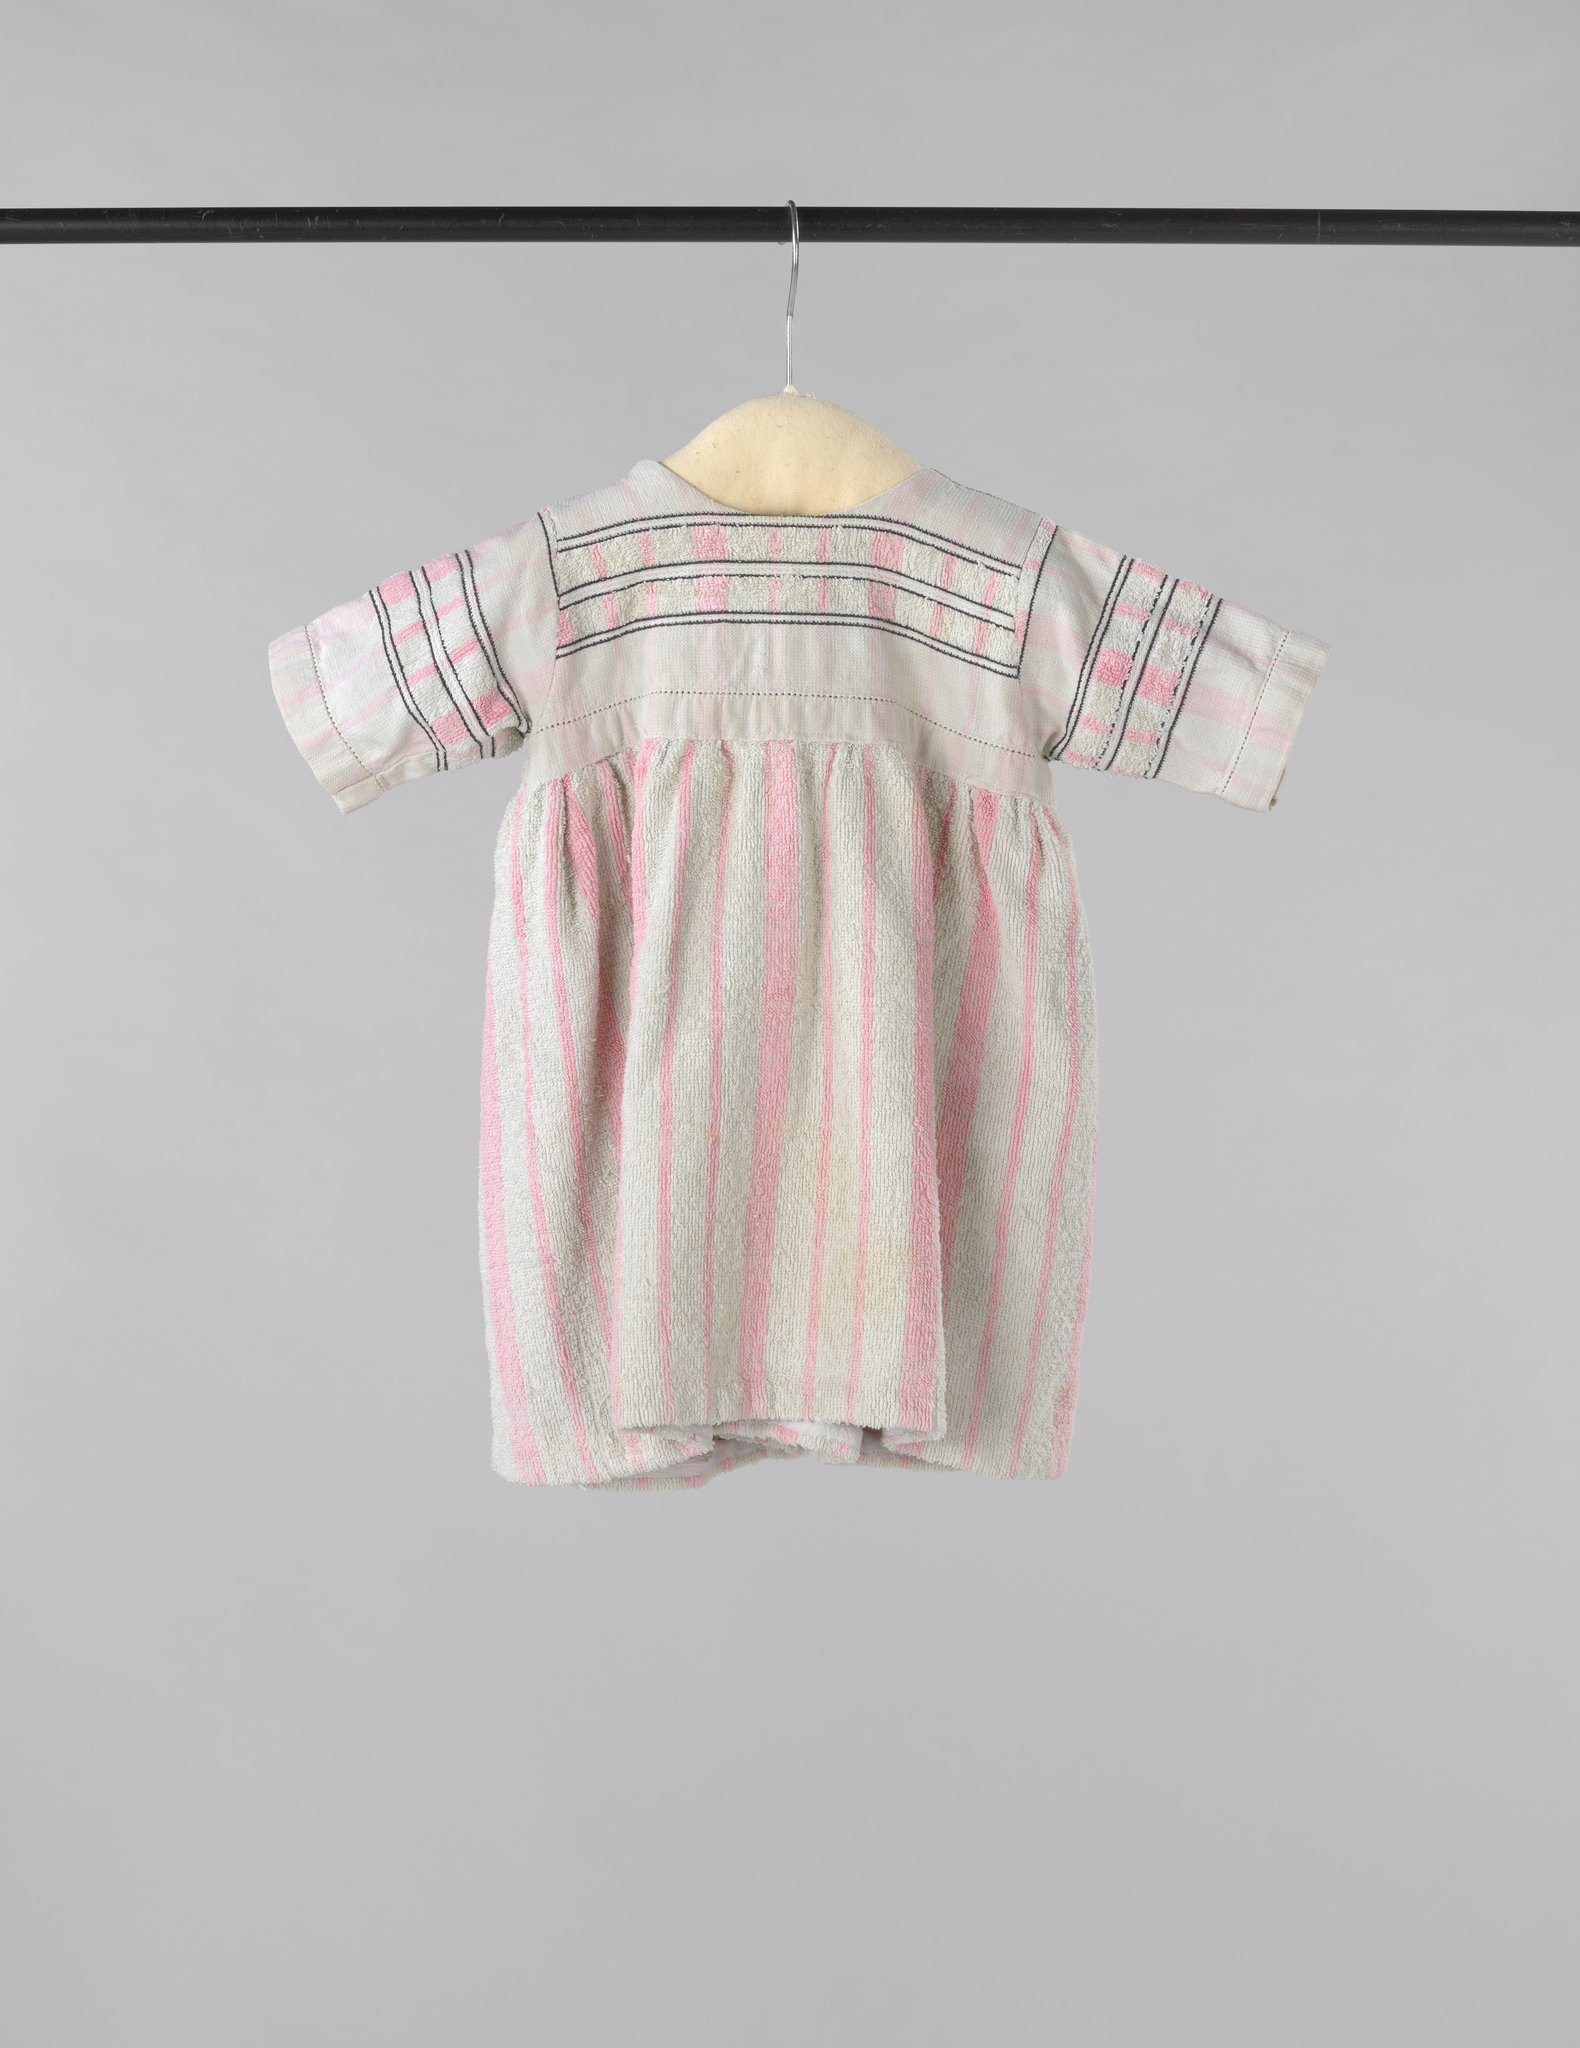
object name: robe, japon, jurk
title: Kinderjurk met korte mouw, gemaakt van een wit-roze gestreepte badstoffen handdoek, op het lijf afgezet met zwarte siernaden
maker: harmina catharina baruch-ponstijn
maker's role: maker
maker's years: 1909-1993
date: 1948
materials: textile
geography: amsterdam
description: Kinderjurk met korte mouw, gemaakt van een wit-roze gestreepte badstoffen handdoek, op het lijf afgezet met zwarte siernaden. Model: Princesse-lijn. Hoge taille waaraan de gerende rok is gerimpeld. Kort lijfje met ronde hals zonder kraag en korte mouwen. Blinde sluiting middenachter. Versiering: de handdoek is zo verwerkt dat de versierde rand is gebruikt voor het lijfje en de mouwen, terwijl de rok geheel uit de wit/roze gestreepte badstof bestaat. Gedragen door Henriëtte Johanna Baruch.